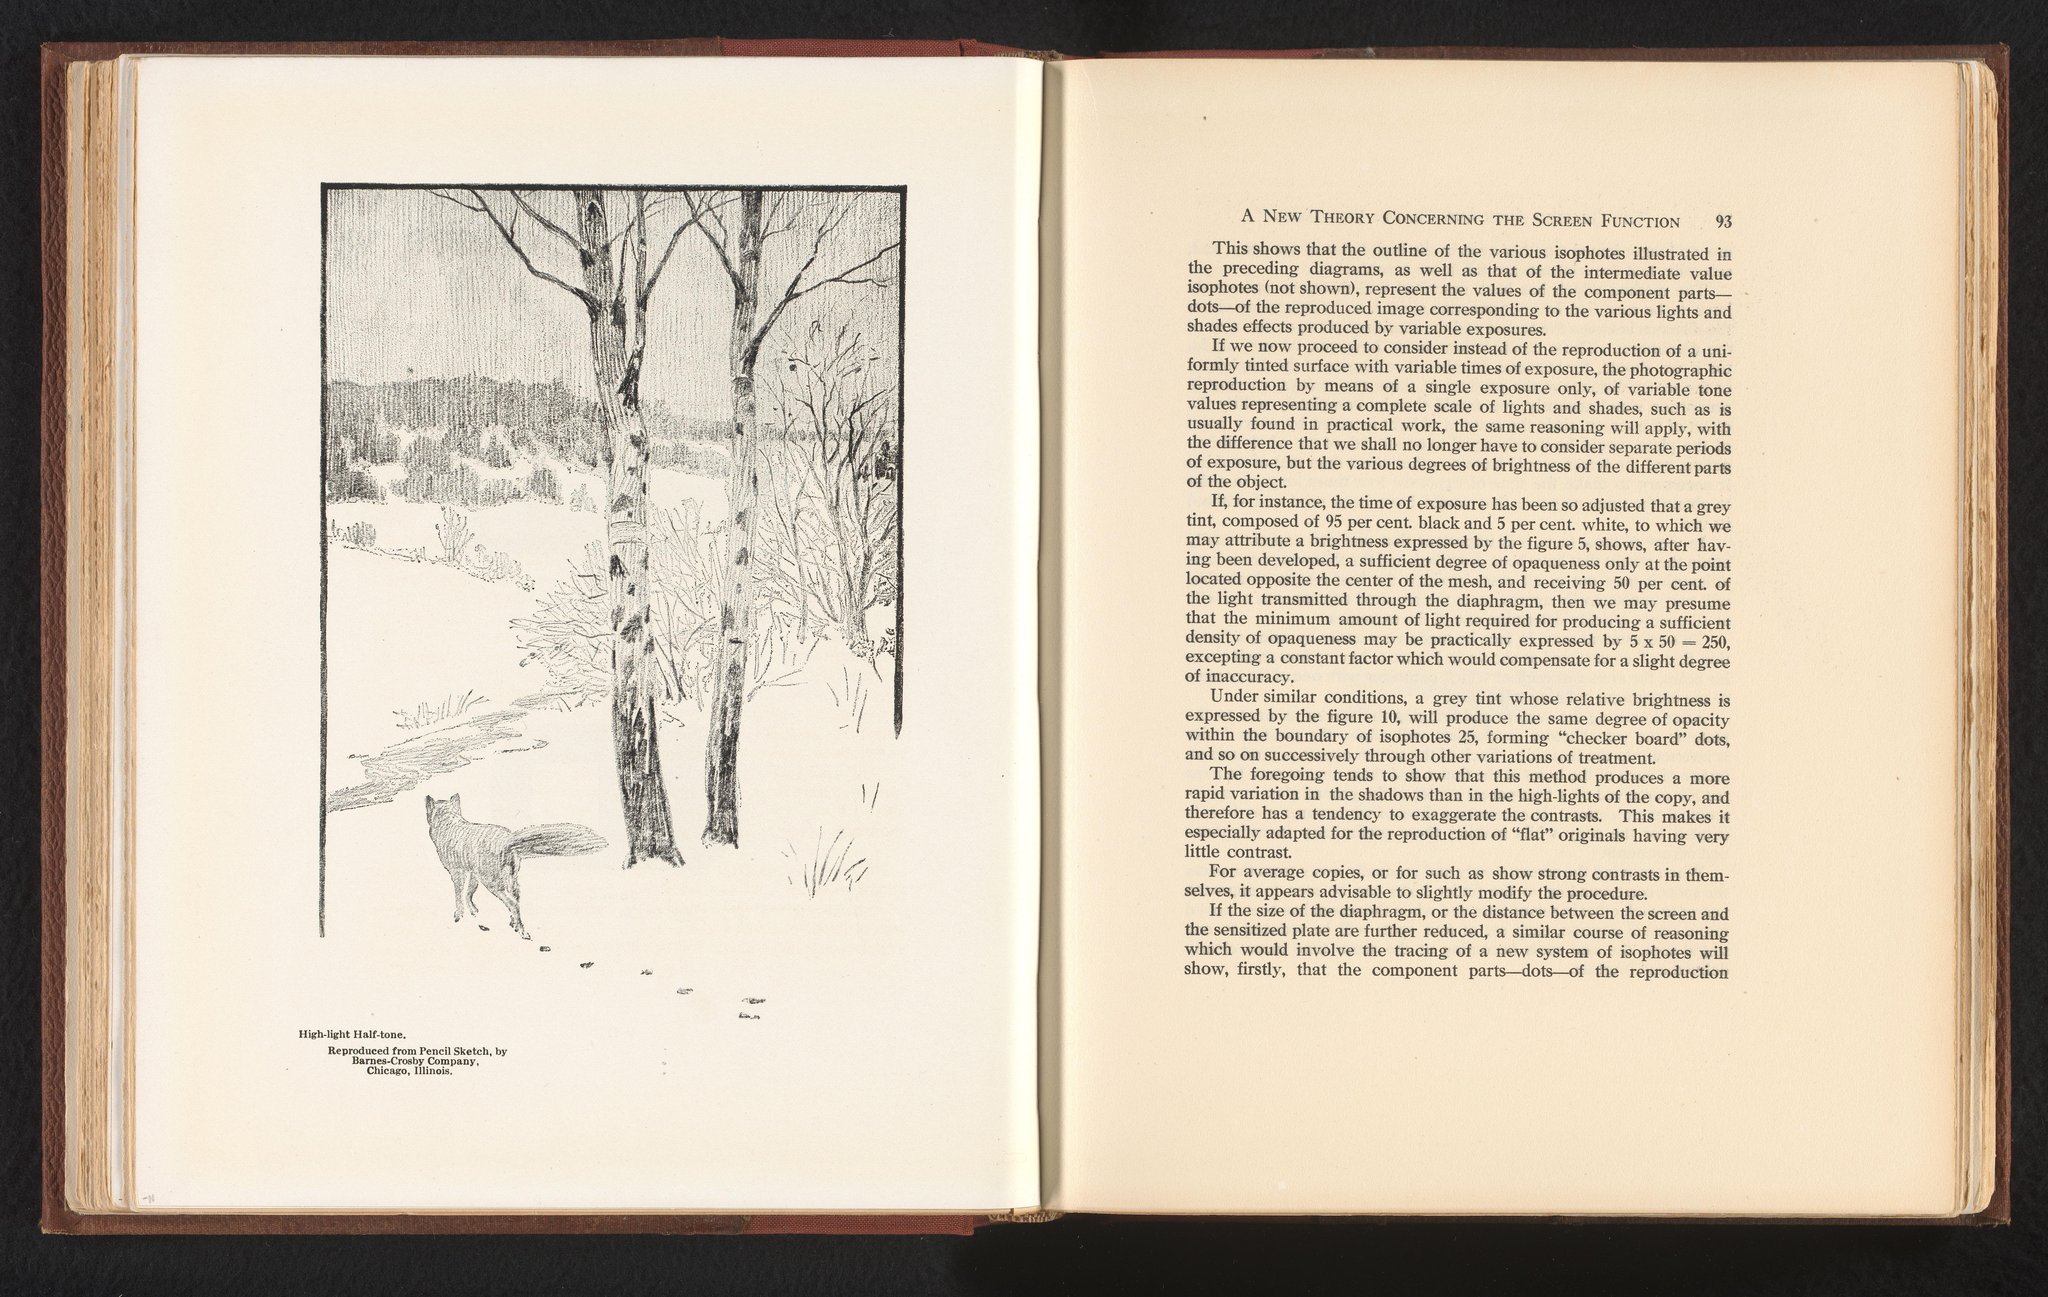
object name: reproduction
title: Reproductie van een potloodtekening van een vos in sneeuwlandschap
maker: Anonymous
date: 1904-1909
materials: paper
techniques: autotype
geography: chicago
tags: forest, wood, snow, beasts of prey, predatory animals: fox